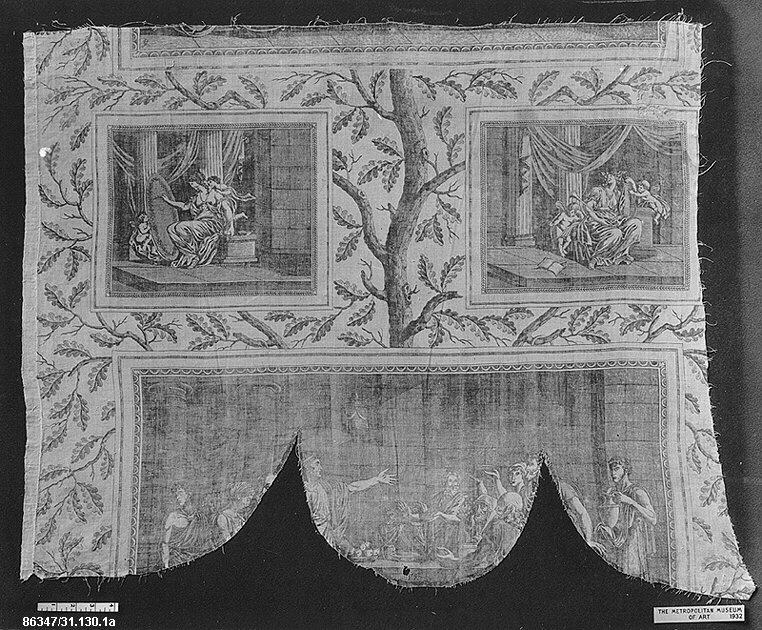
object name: fragment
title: "The Arts"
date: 1801-1833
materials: cotton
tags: men,women,putti